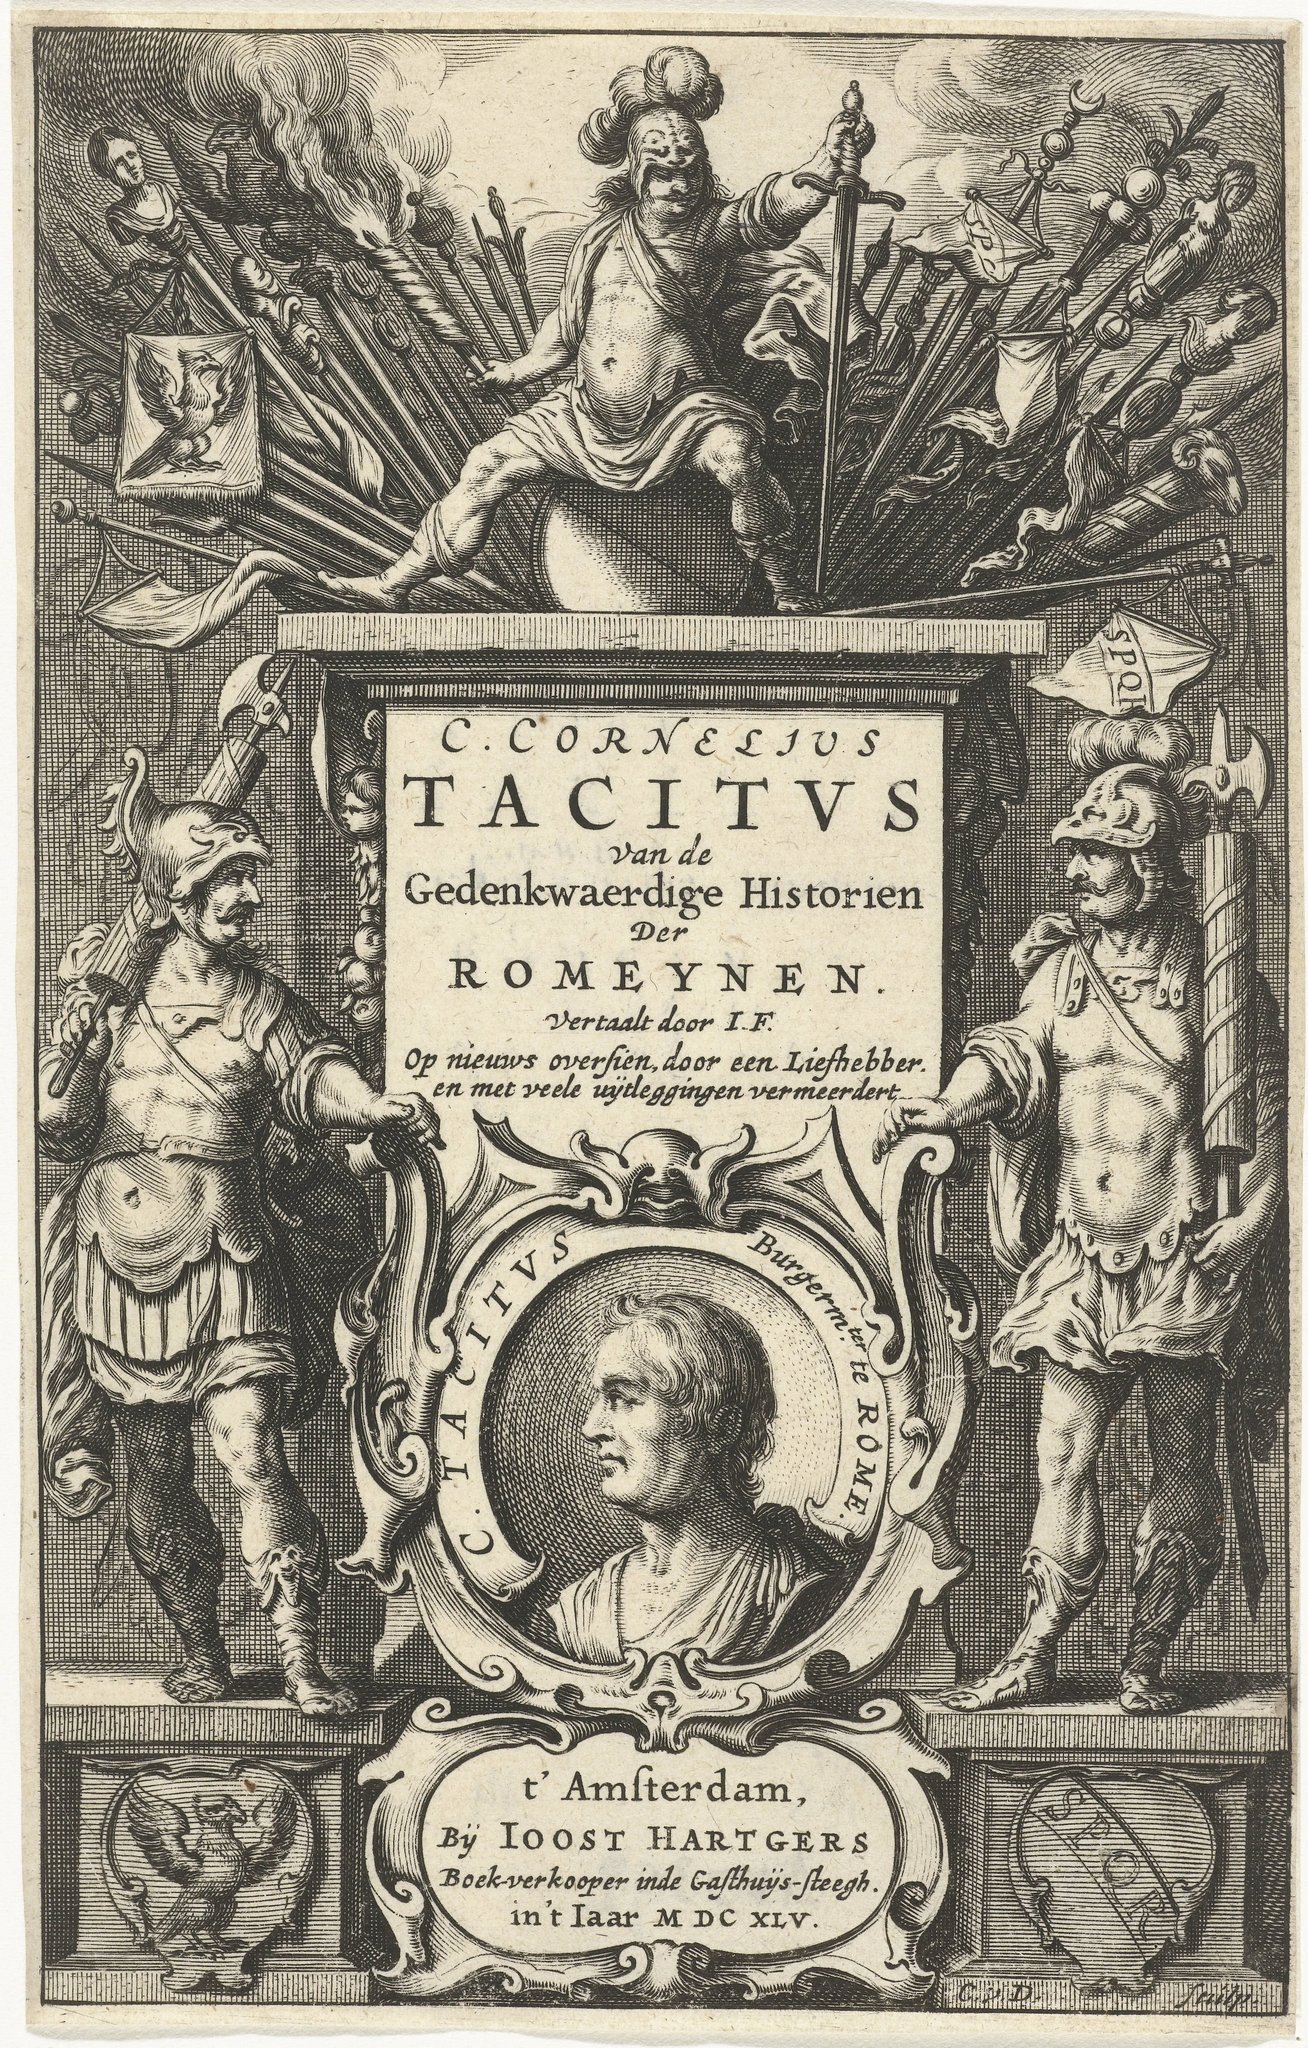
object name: print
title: Vande ghedenkwaerdige geschiedenissen der Romeinen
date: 1645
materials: paper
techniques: engraving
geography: amsterdam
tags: publius cornelius tacitus, (story of) mars (ares)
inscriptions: collector's mark: Lugt 2228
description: Titelpagina voor: Publius Cornelius Tacitus (vertaler: Johannes Vennekool ), Vande ghedenkwaerdige geschiedenissen der Romeinen, Joost Hartgers (uitgever), Amsterdam 1645